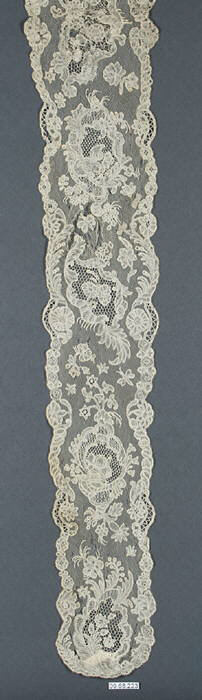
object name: lappet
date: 1701-1800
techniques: lace